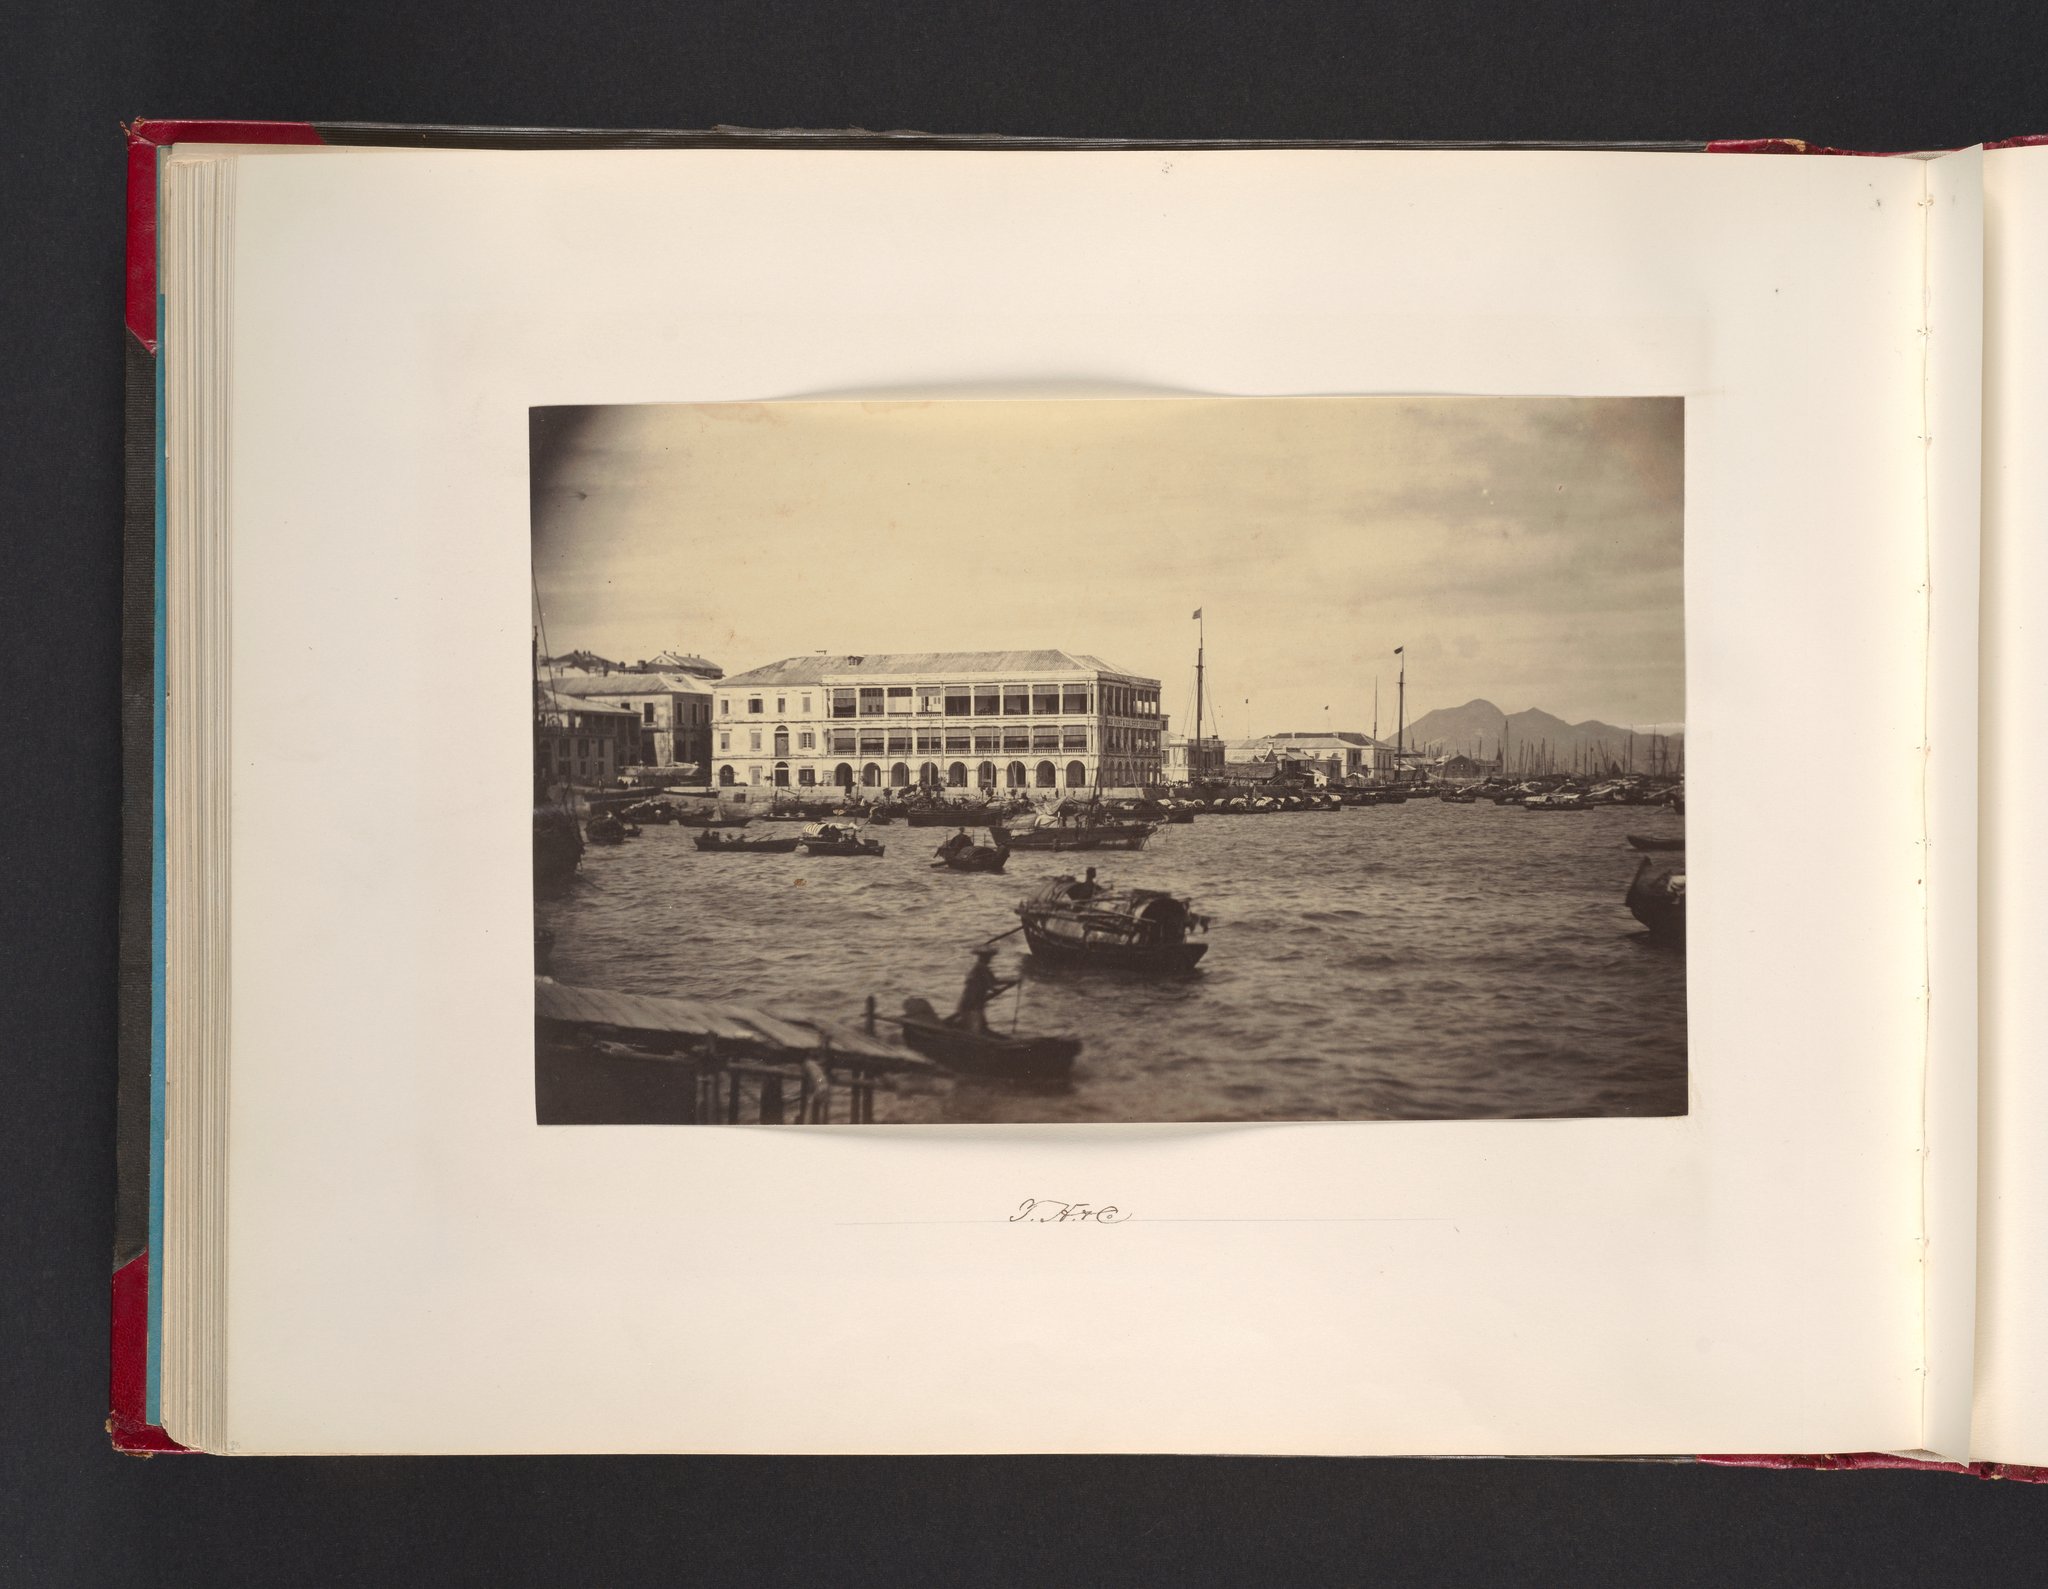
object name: photograph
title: T. H. & Co.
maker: john thomson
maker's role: artist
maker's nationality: british, scottish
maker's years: 1837-1921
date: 1865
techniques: albumen silver print, glass negative